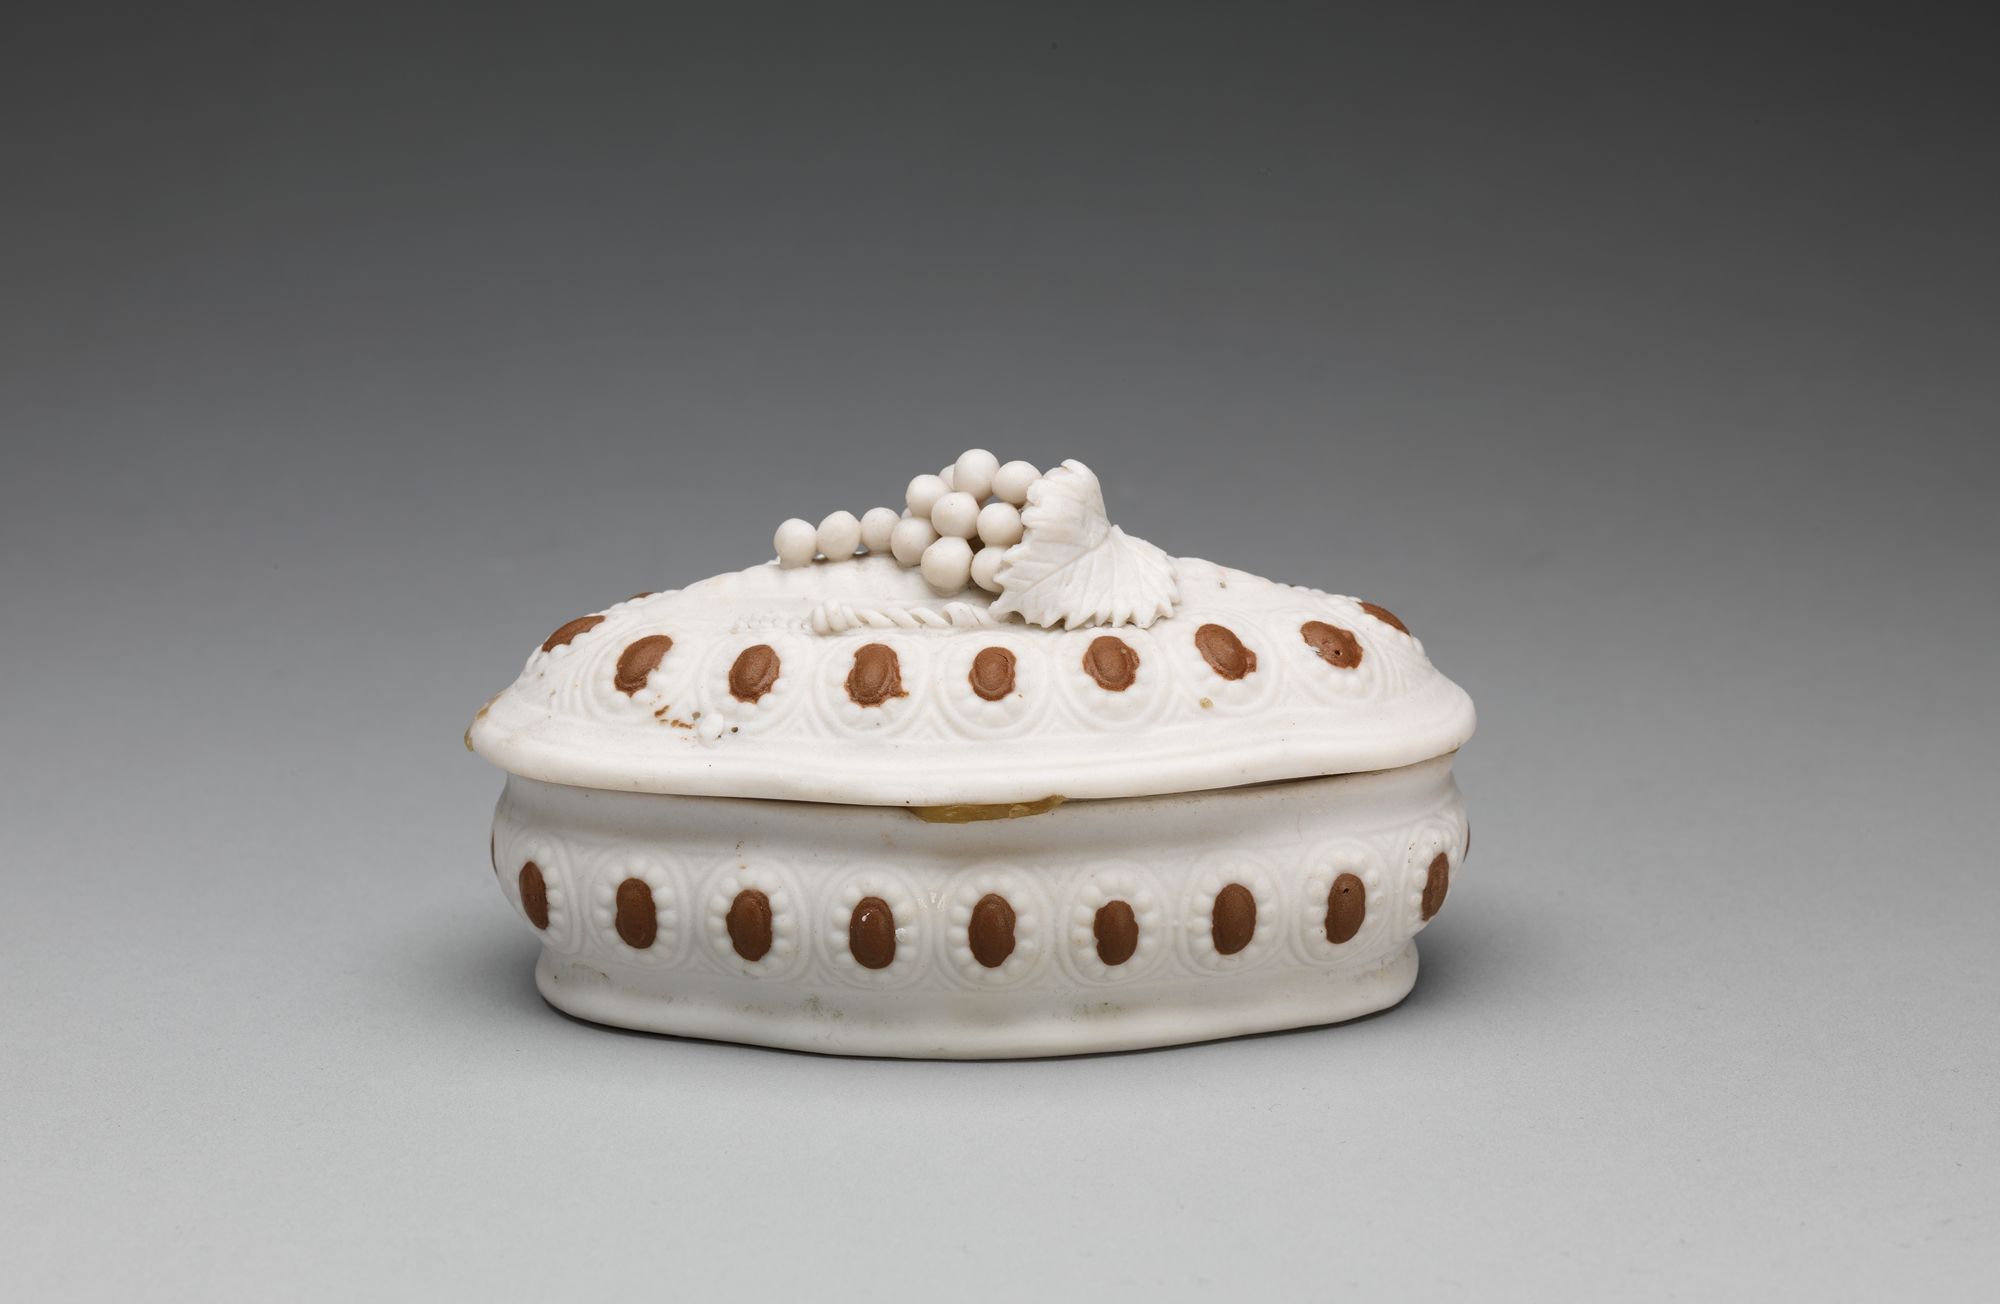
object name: trinket box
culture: american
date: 1830-1870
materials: porcelain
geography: united states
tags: grapes